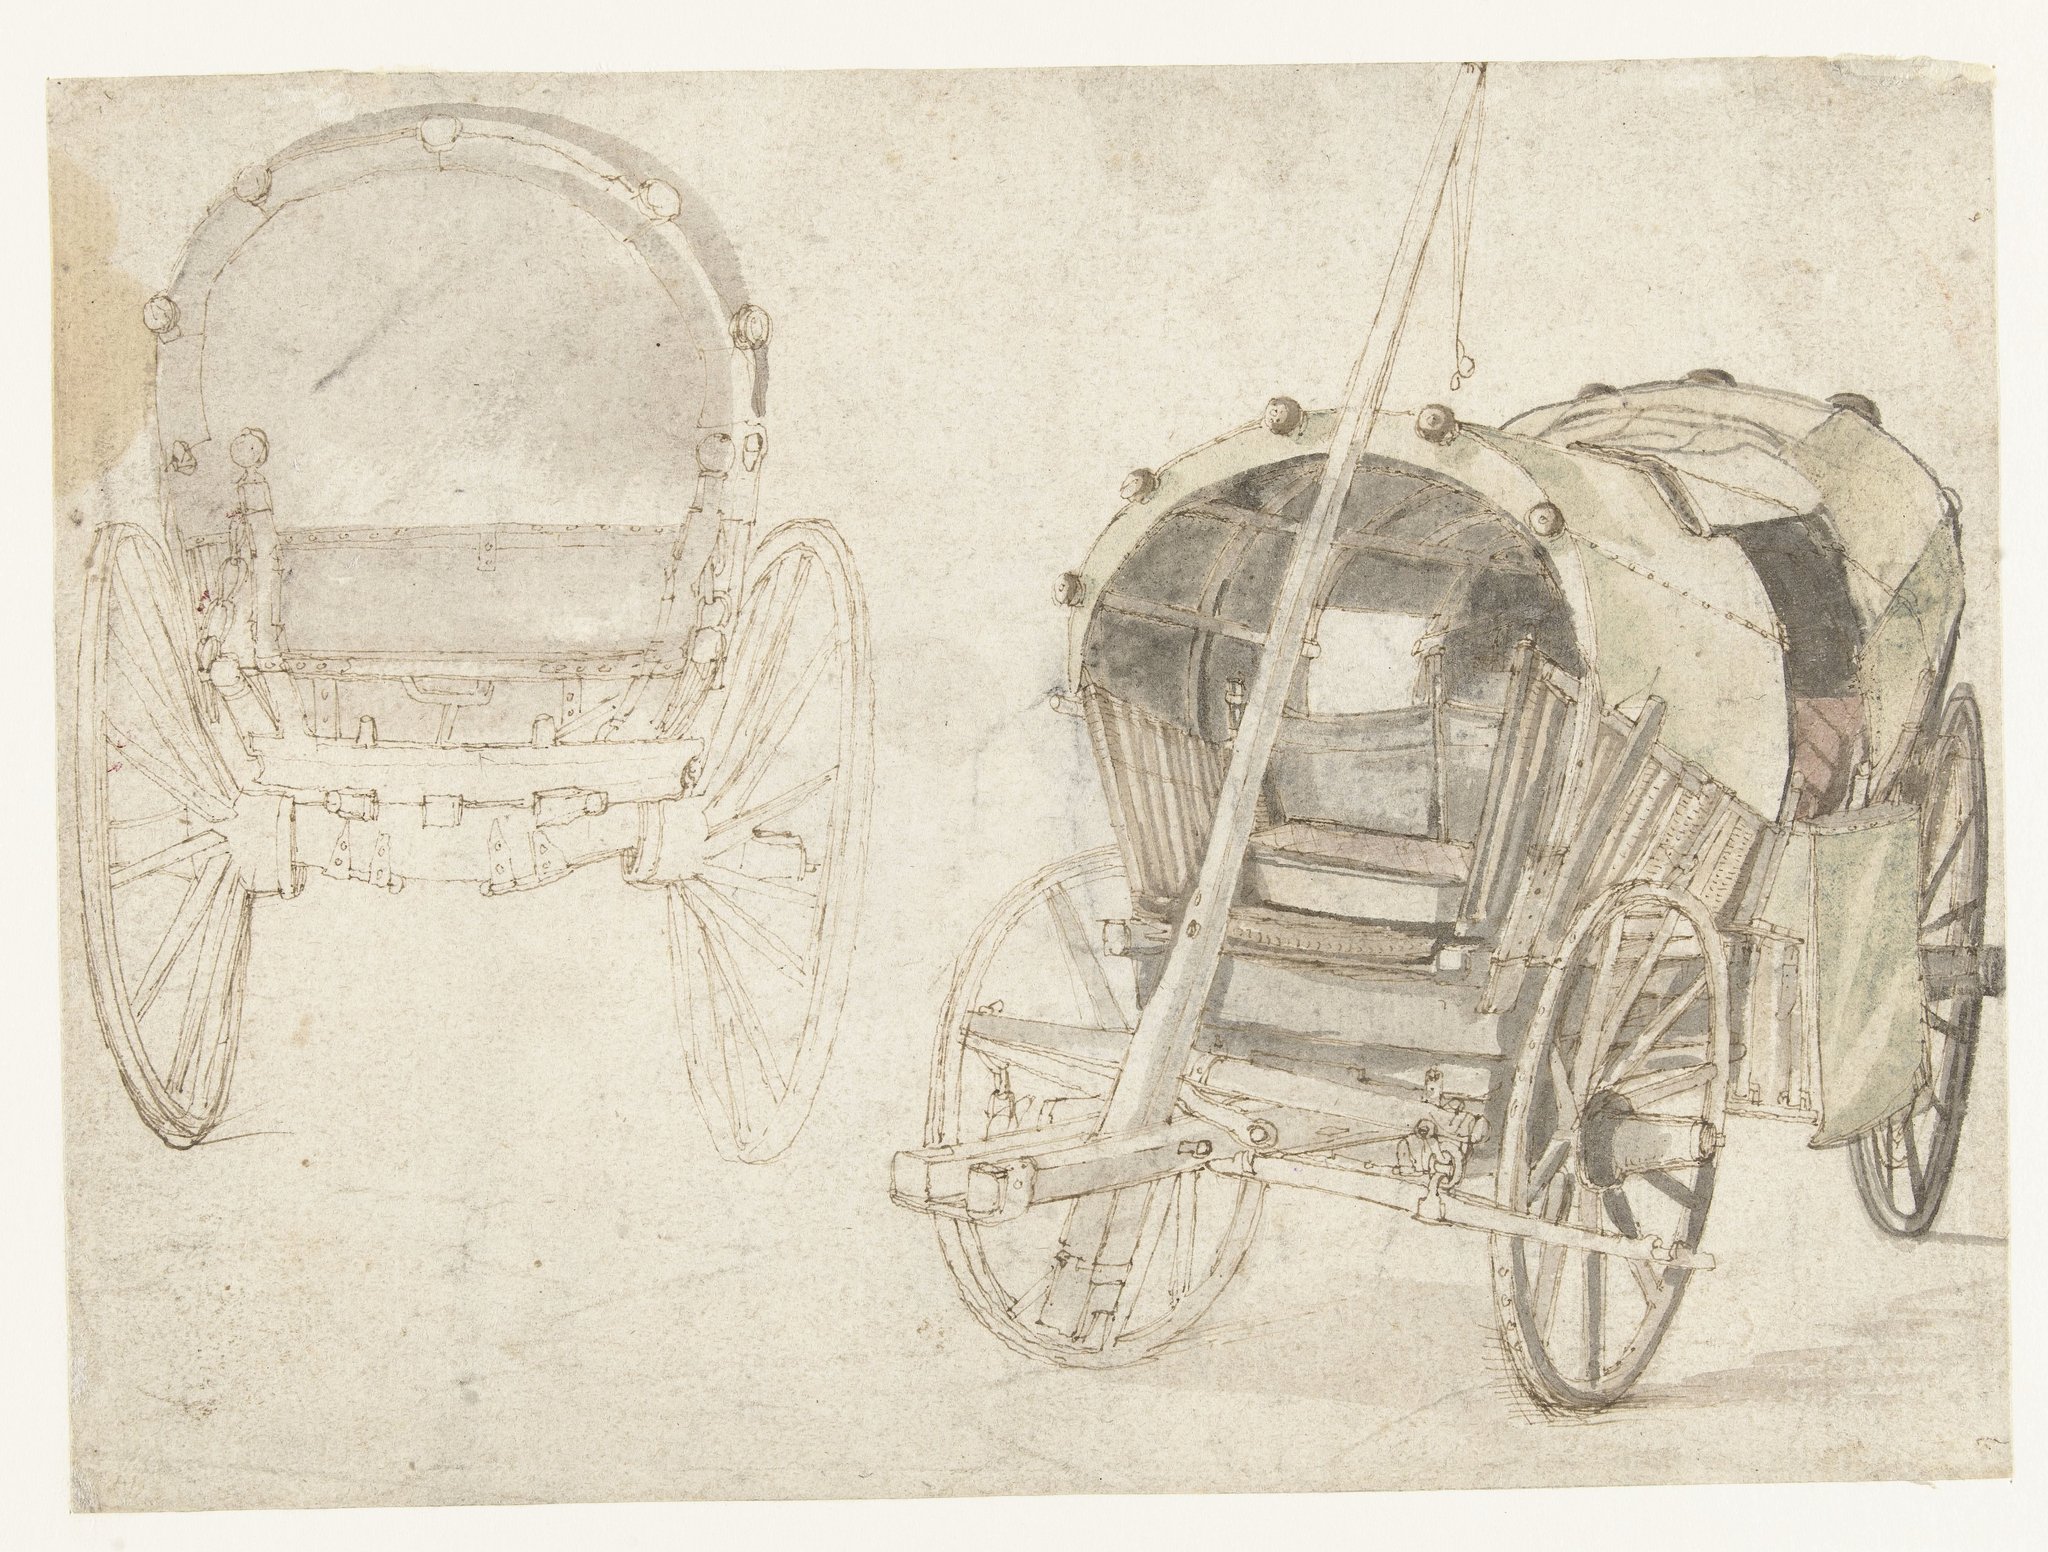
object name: drawing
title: Twee reiswagens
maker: gilles neyts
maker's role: draughtsman, print maker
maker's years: 1623-1687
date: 1633-1687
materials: paper, watercolor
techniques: brush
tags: four-wheeled, animal-drawn vehicle, e.g.: cab, carriage, coach